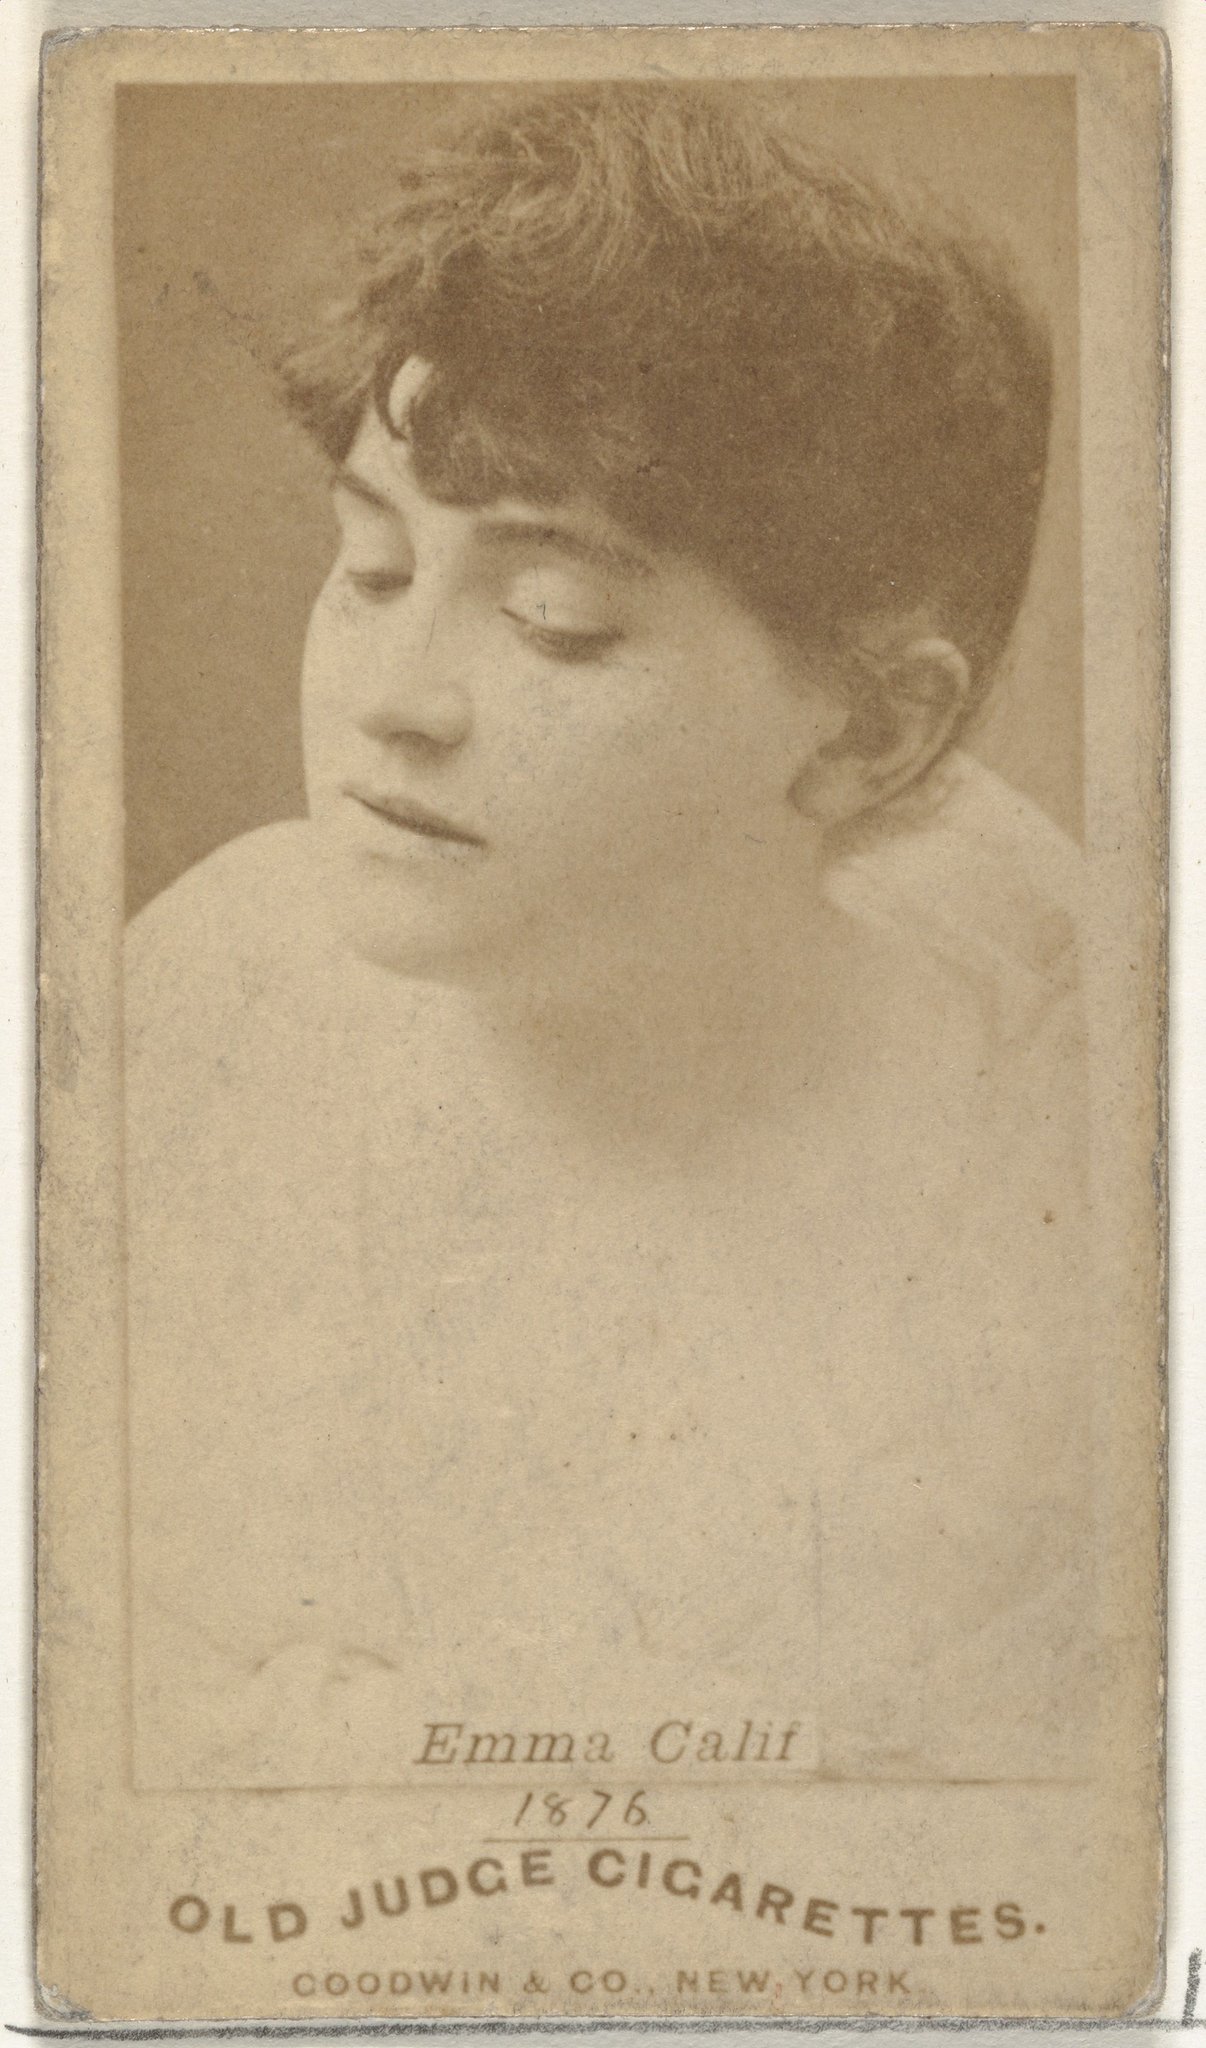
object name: photograph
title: Emma Calif, from the Actors and Actresses series (N171) for Old Judge Cigarettes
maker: goodwin & company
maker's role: publisher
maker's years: 1850-1950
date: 1886-1890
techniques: albumen silver print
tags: portraits,women,actresses